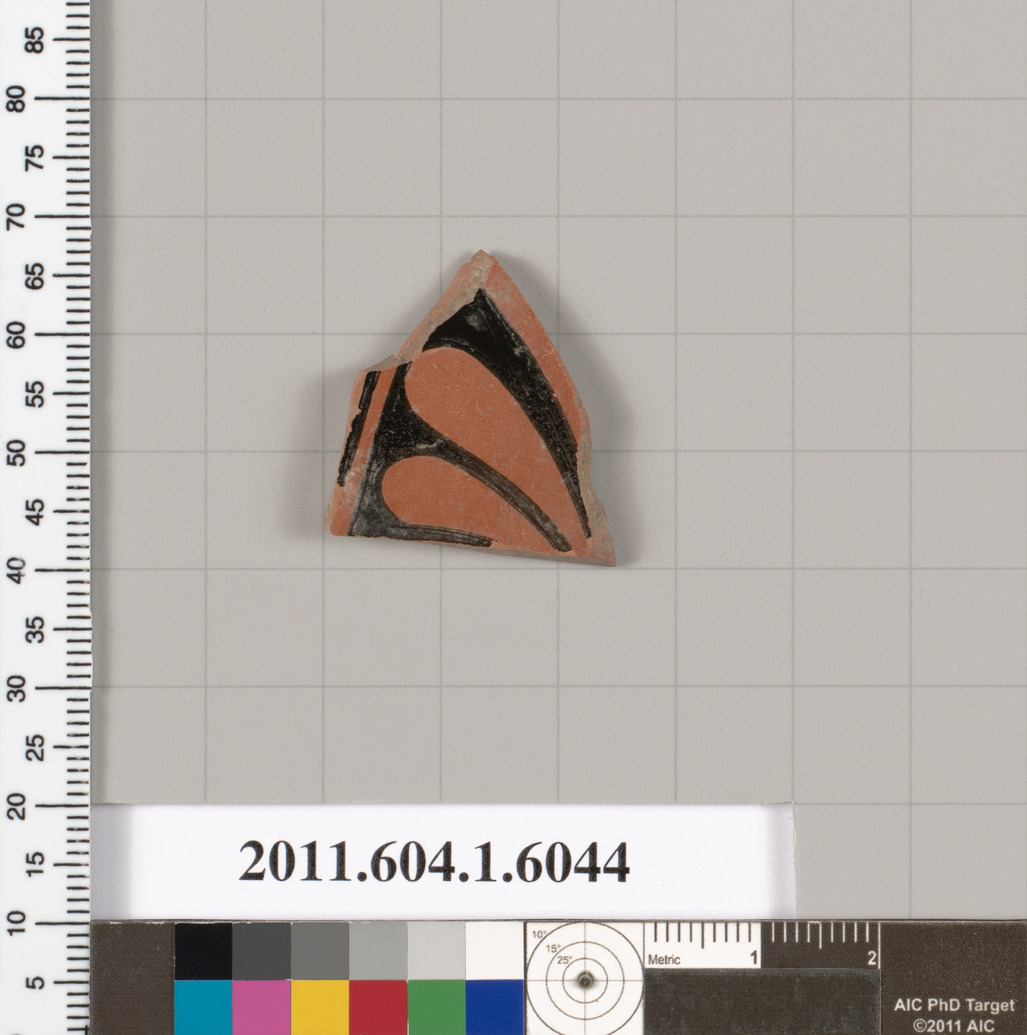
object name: kylix fragment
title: Terracotta fragment of a kylix (drinking cup)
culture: greek, attic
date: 510-500 BCE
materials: terracotta